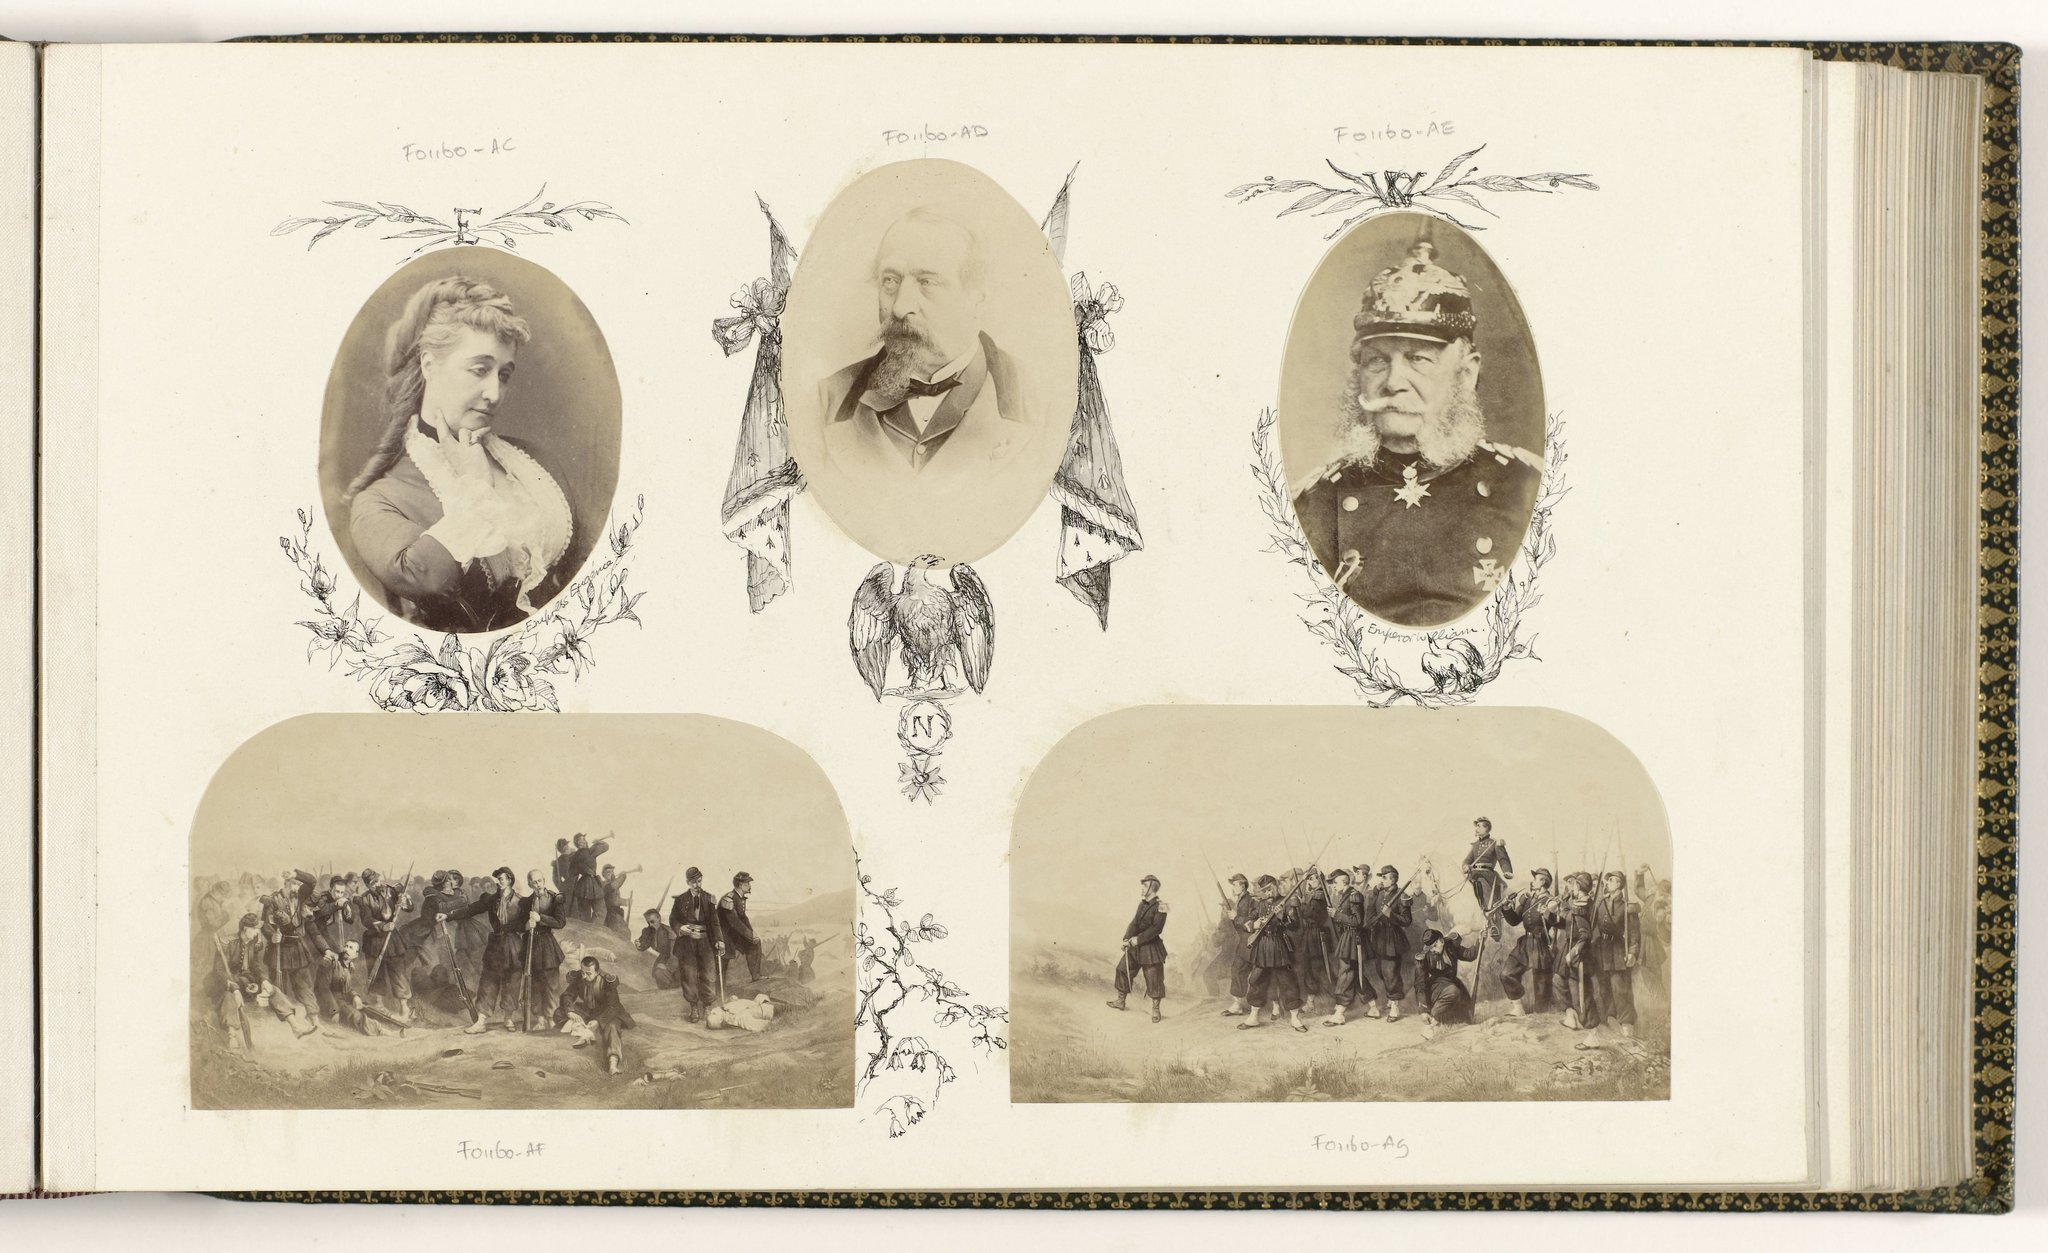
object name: photograph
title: Portret van keizer Wilhelm I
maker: Anonymous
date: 1865-1875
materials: paper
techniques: albumen print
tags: berlin, wilhelm i (keizer van duitsland), historical persons, emperor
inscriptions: inscription: ‘emperor William’